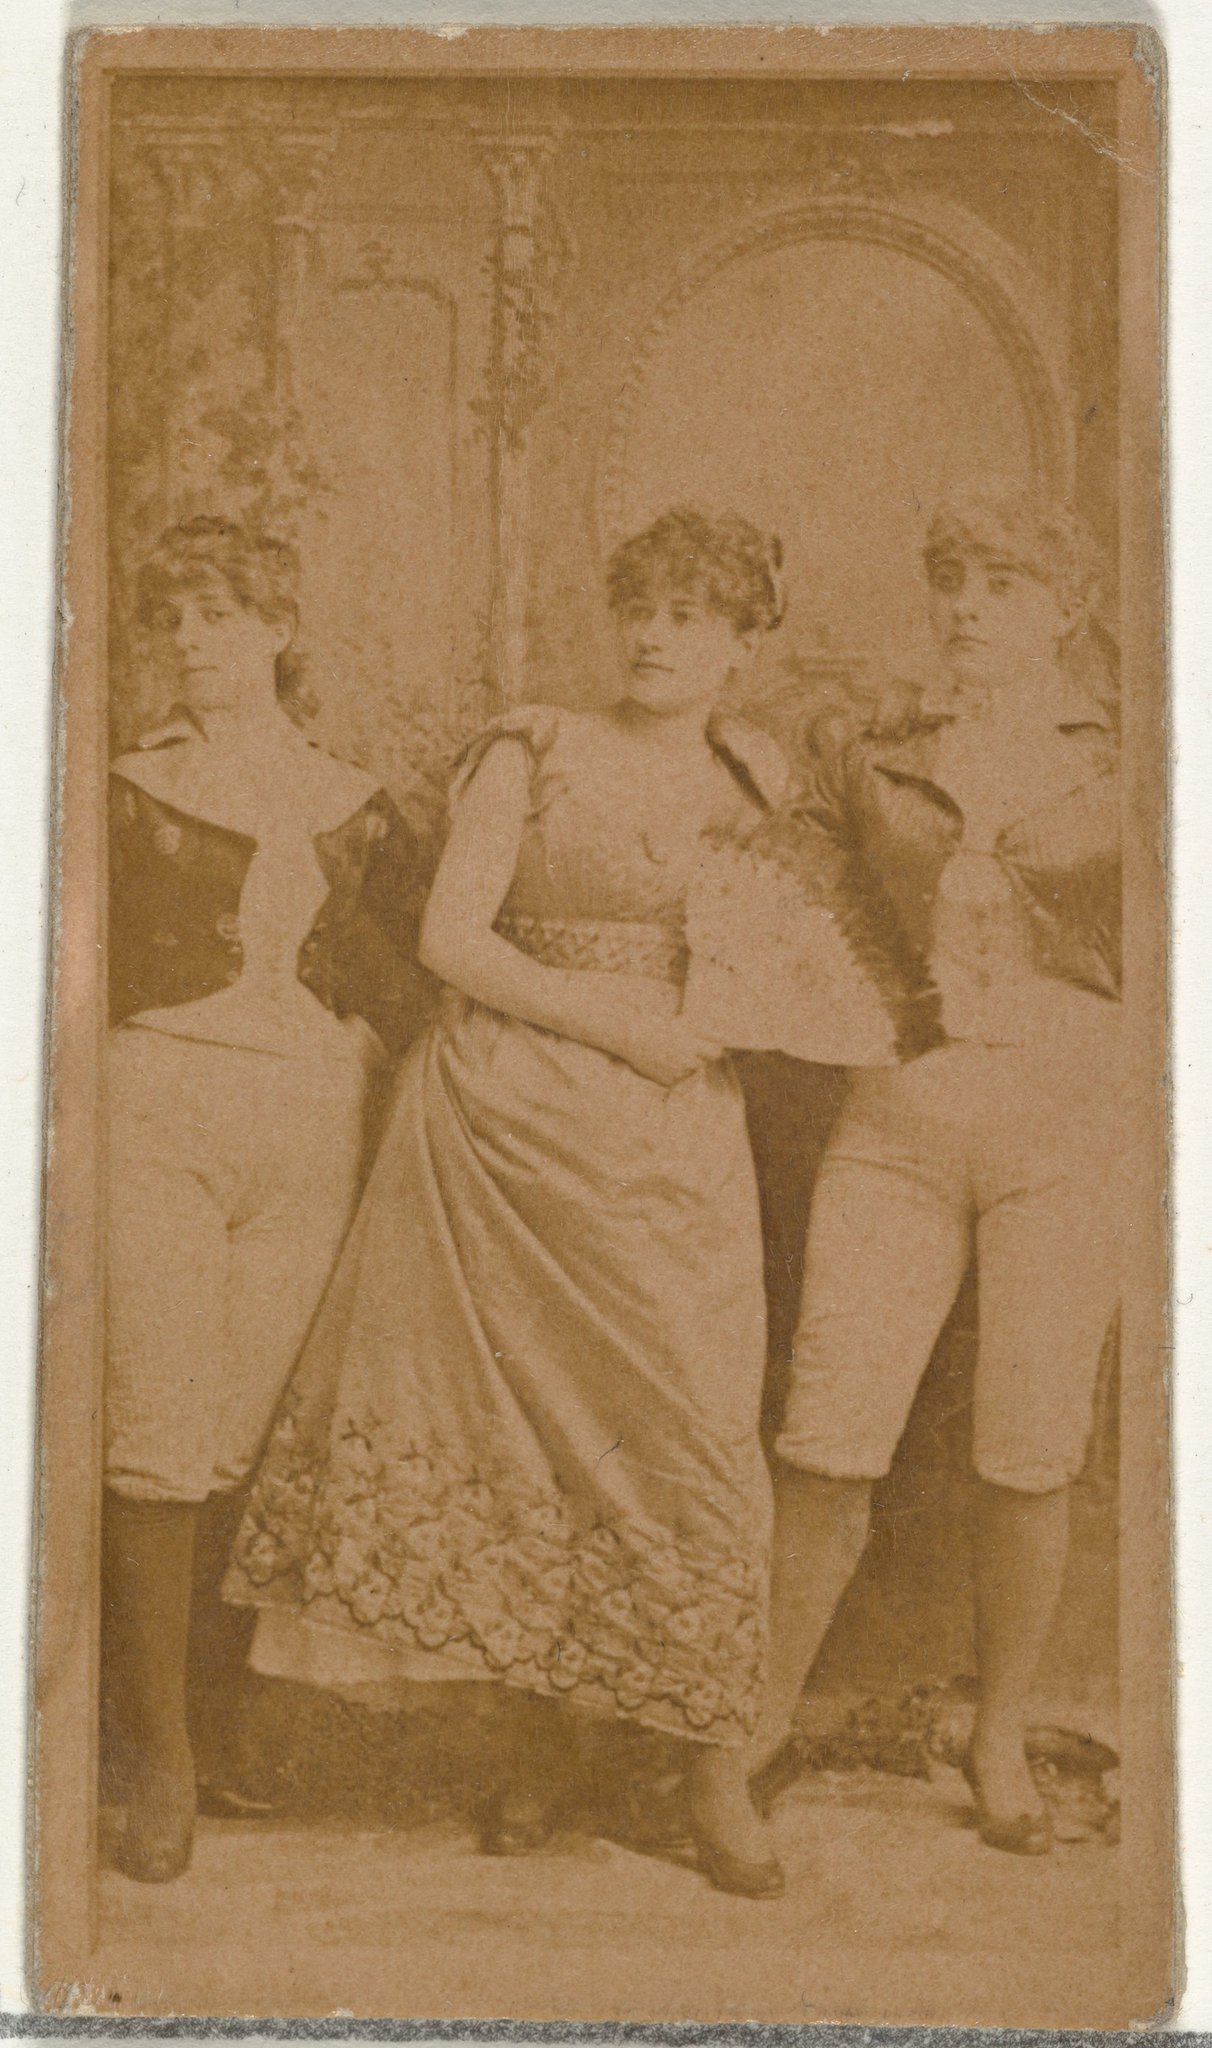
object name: photograph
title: [Three actresses in costume], from the Actors and Actresses series (N145-8) issued by Duke Sons & Co. to promote Duke Cigarettes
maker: w. duke, sons & co.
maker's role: publisher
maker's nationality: american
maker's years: 1870-1920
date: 1891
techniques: albumen silver print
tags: portraits,women,actresses